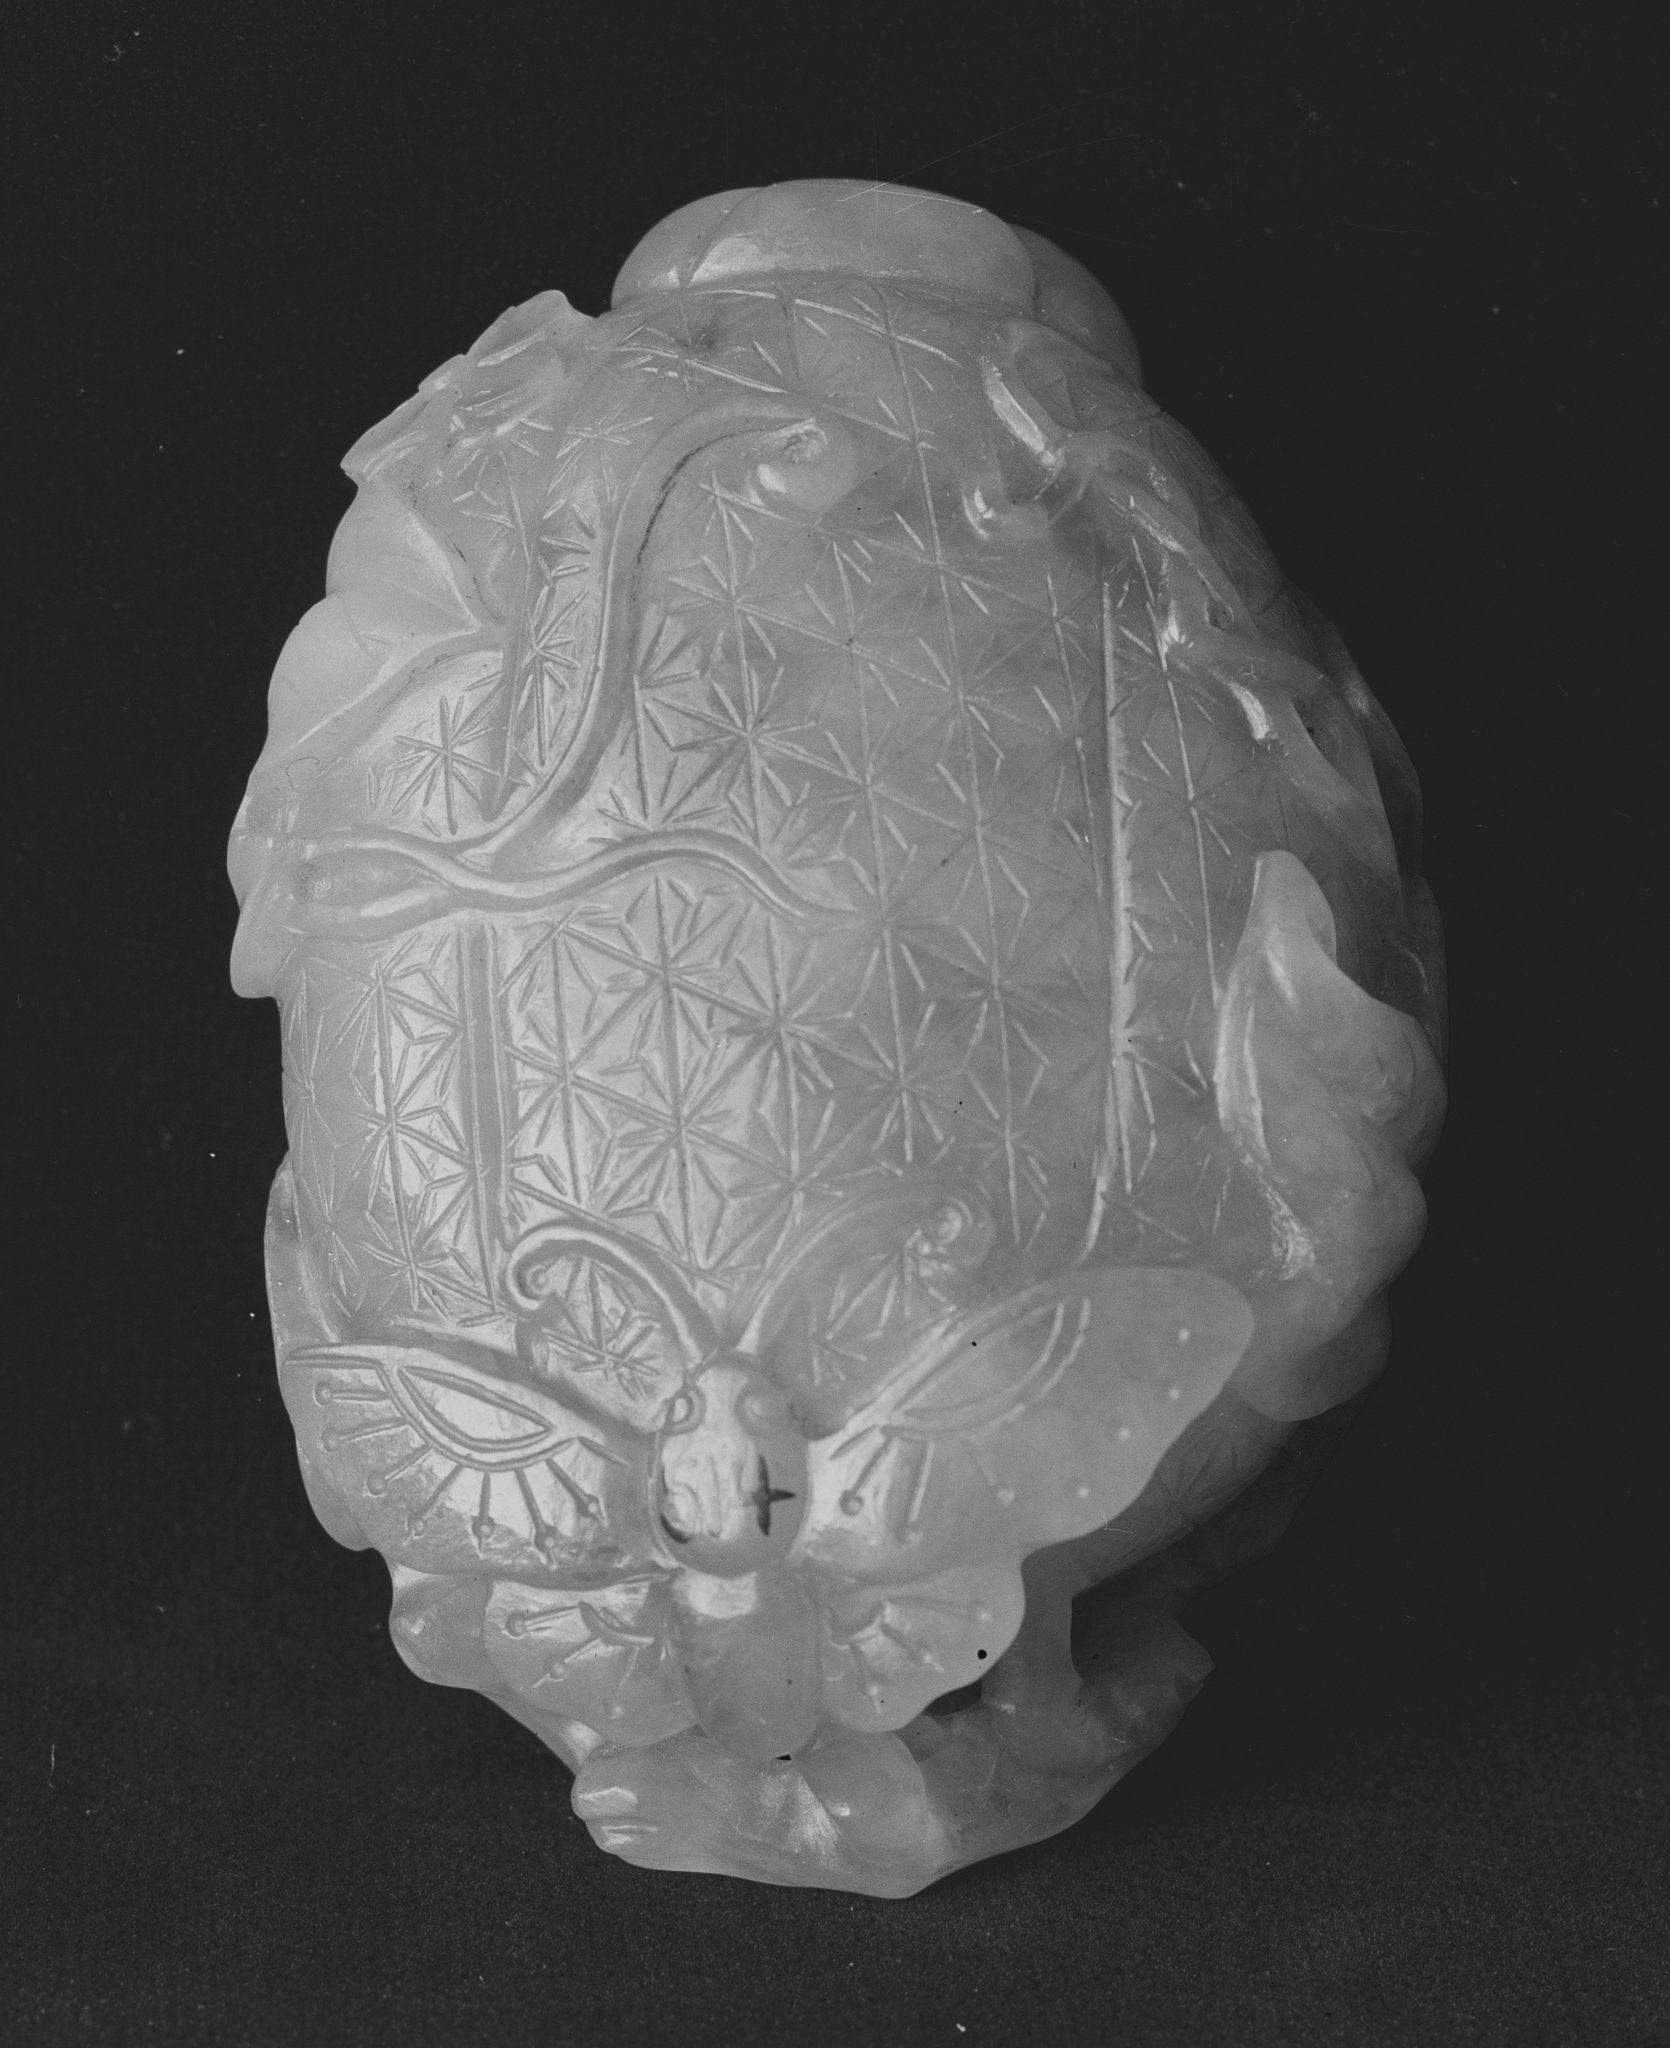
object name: paperweight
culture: chinese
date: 1736-1795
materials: jade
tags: butterflies